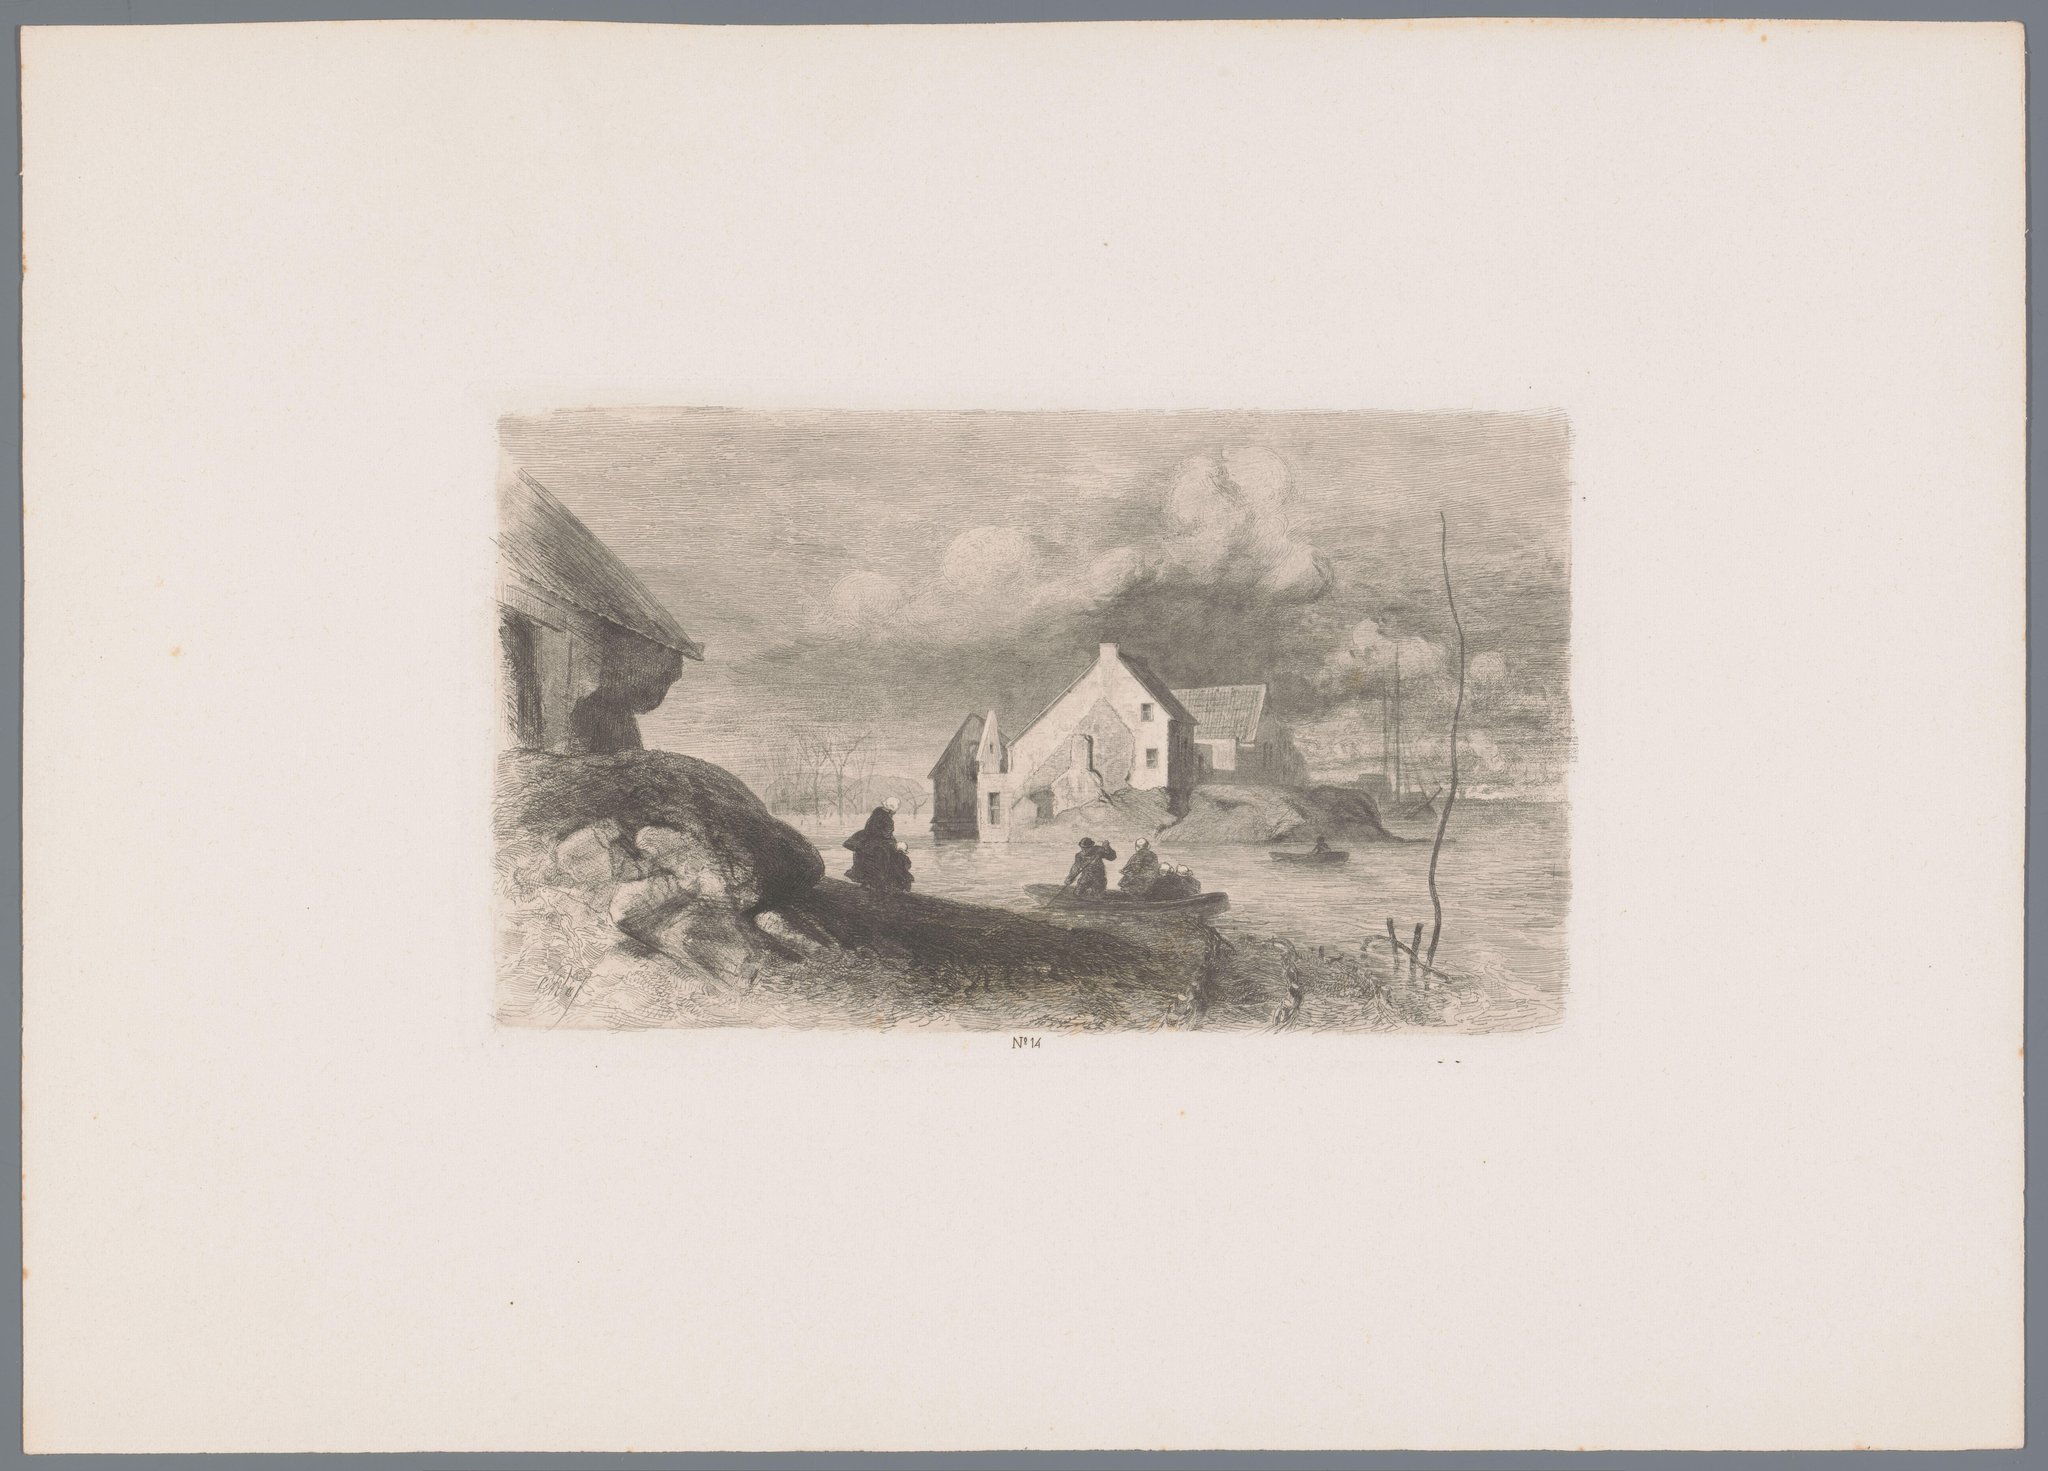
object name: print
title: Doorbraak te Lith, 23 Maart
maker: charles rochussen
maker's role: draughtsman, painter, print maker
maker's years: 1814-1894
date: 1855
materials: paper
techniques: etching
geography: netherlands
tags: dike-break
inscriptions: collector's mark: Lugt 2228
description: De doorgebroken dijk bij Lith, 23 maart 1855. Onderdeel van de reeks van 24 prenten over de watersnood van maart 1855, door leden van het genootschap Arti et Amicitiae. Uitgave ten behoeve van de slachtoffers van de watersnood.